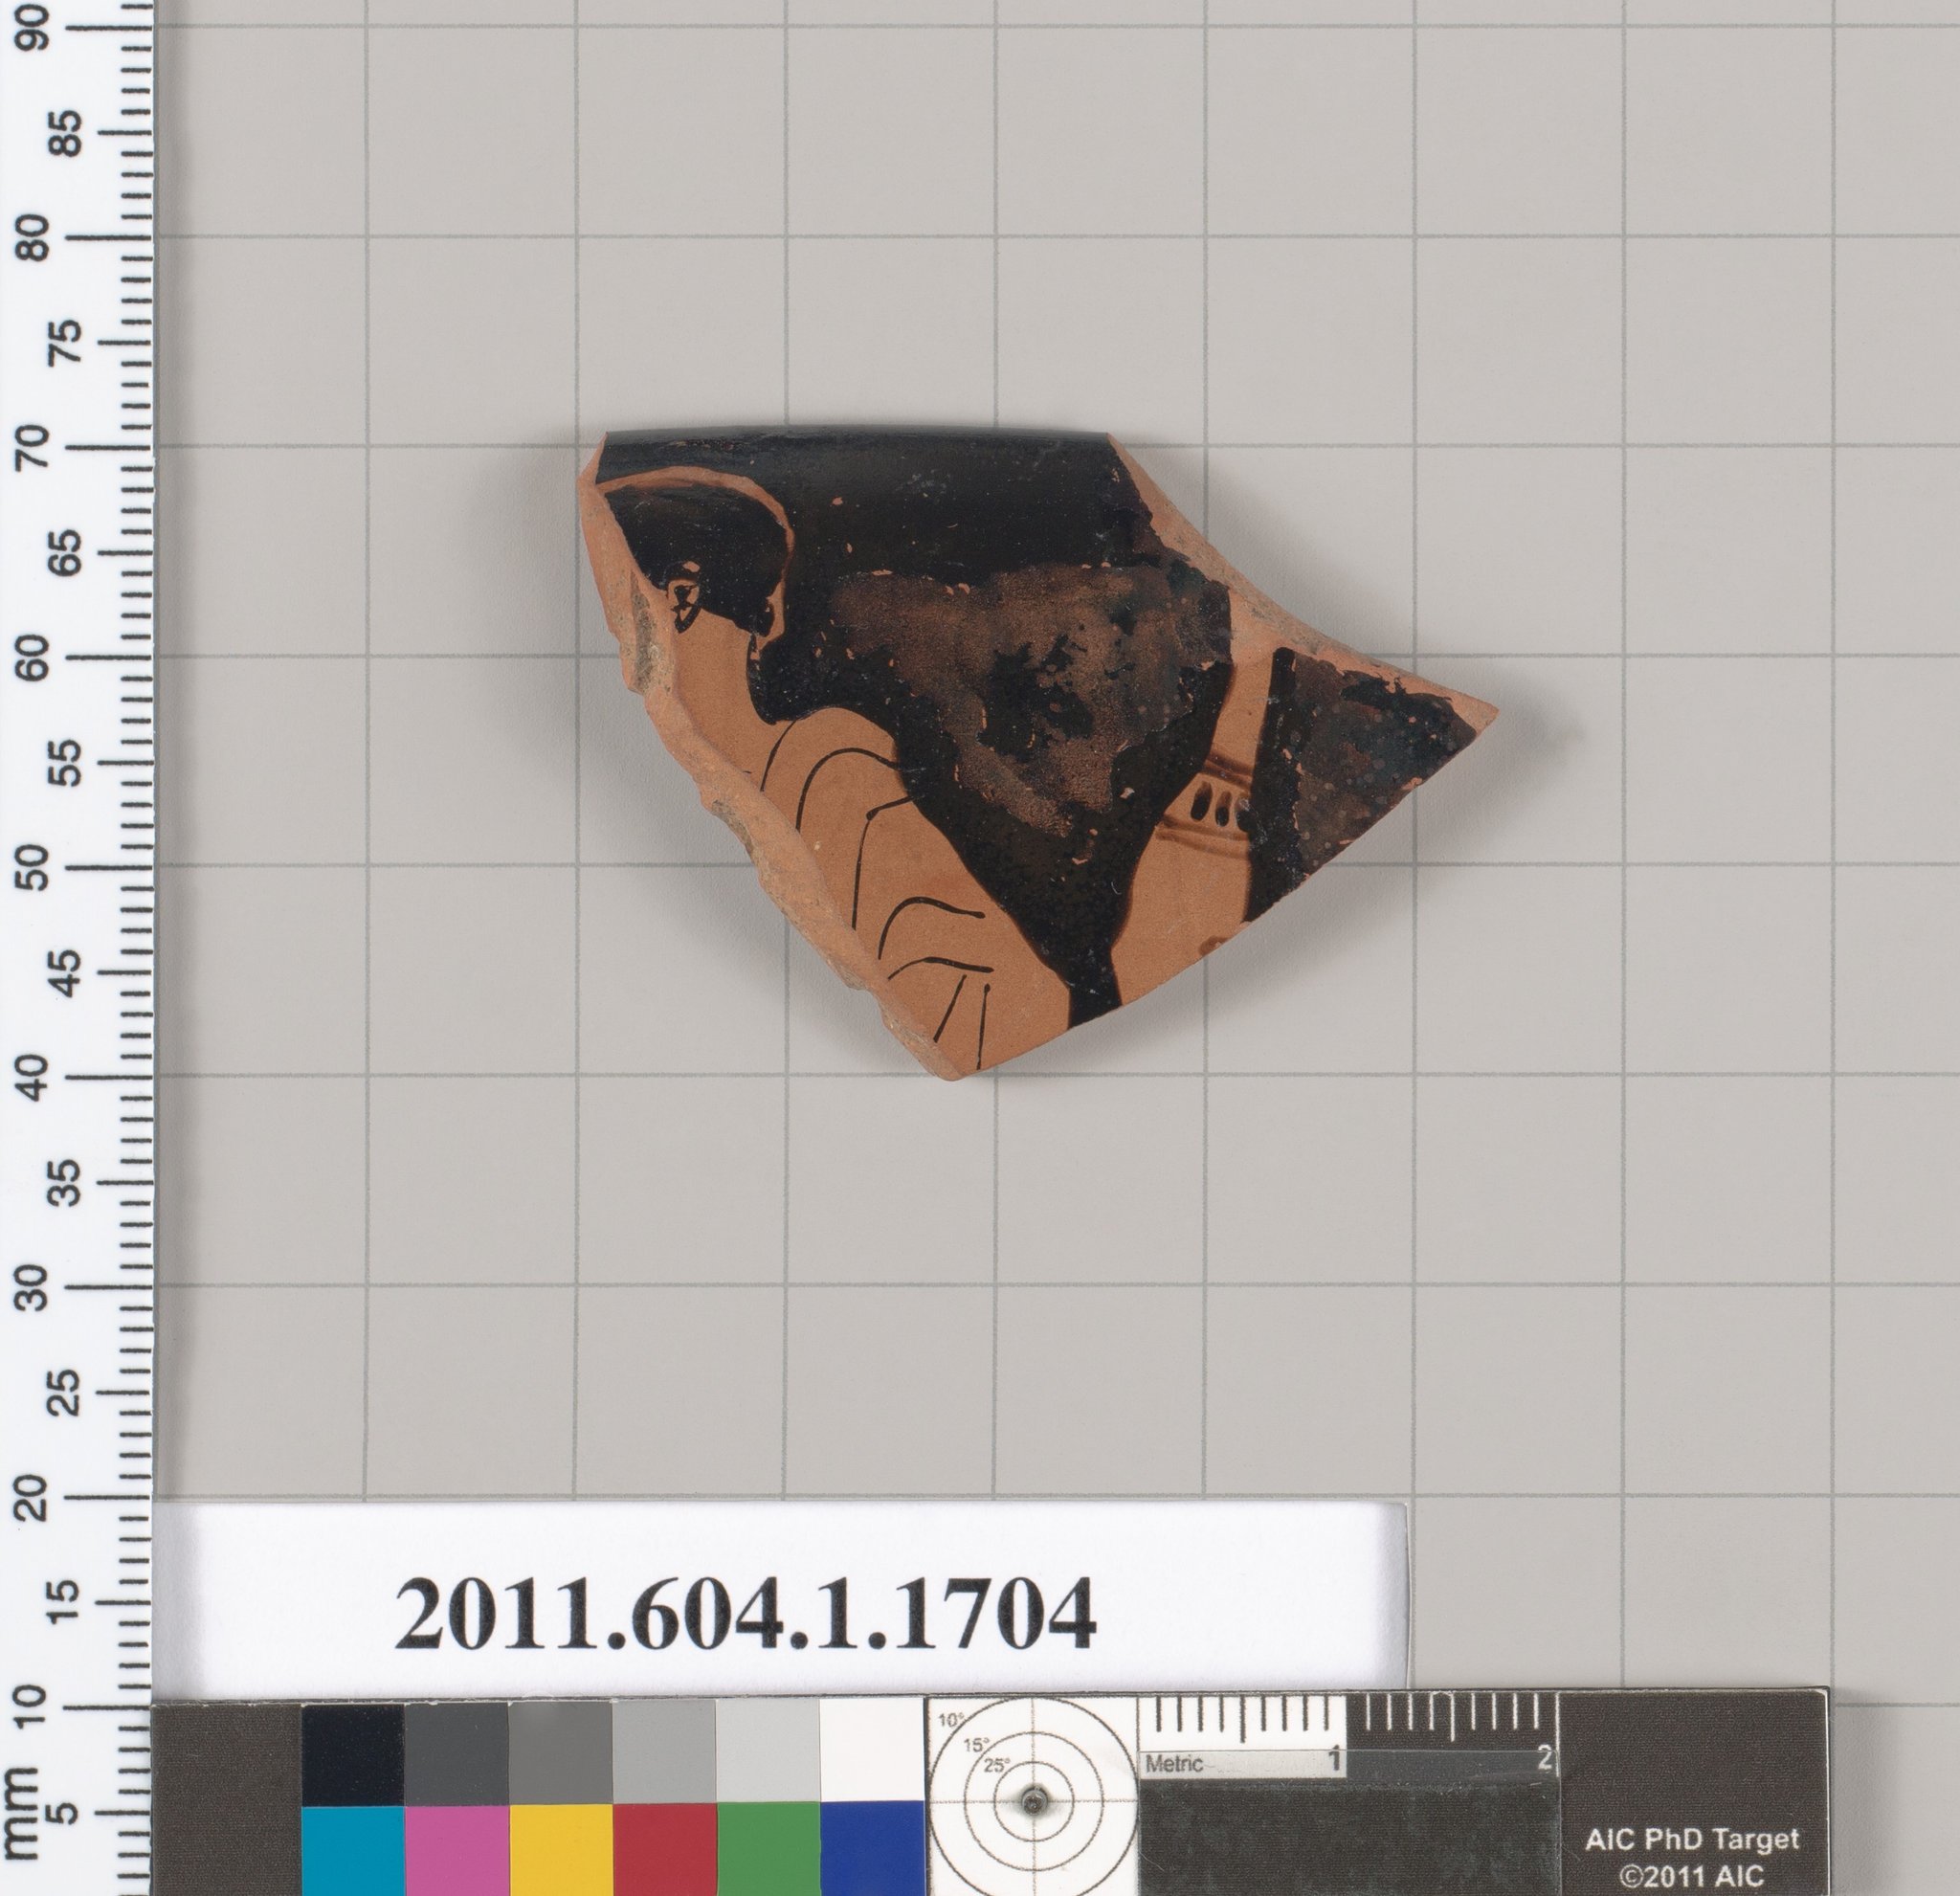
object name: kylix fragment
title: Terracotta rim fragment of a kylix (drinking cup)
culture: greek, attic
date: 480-470 BCE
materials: terracotta